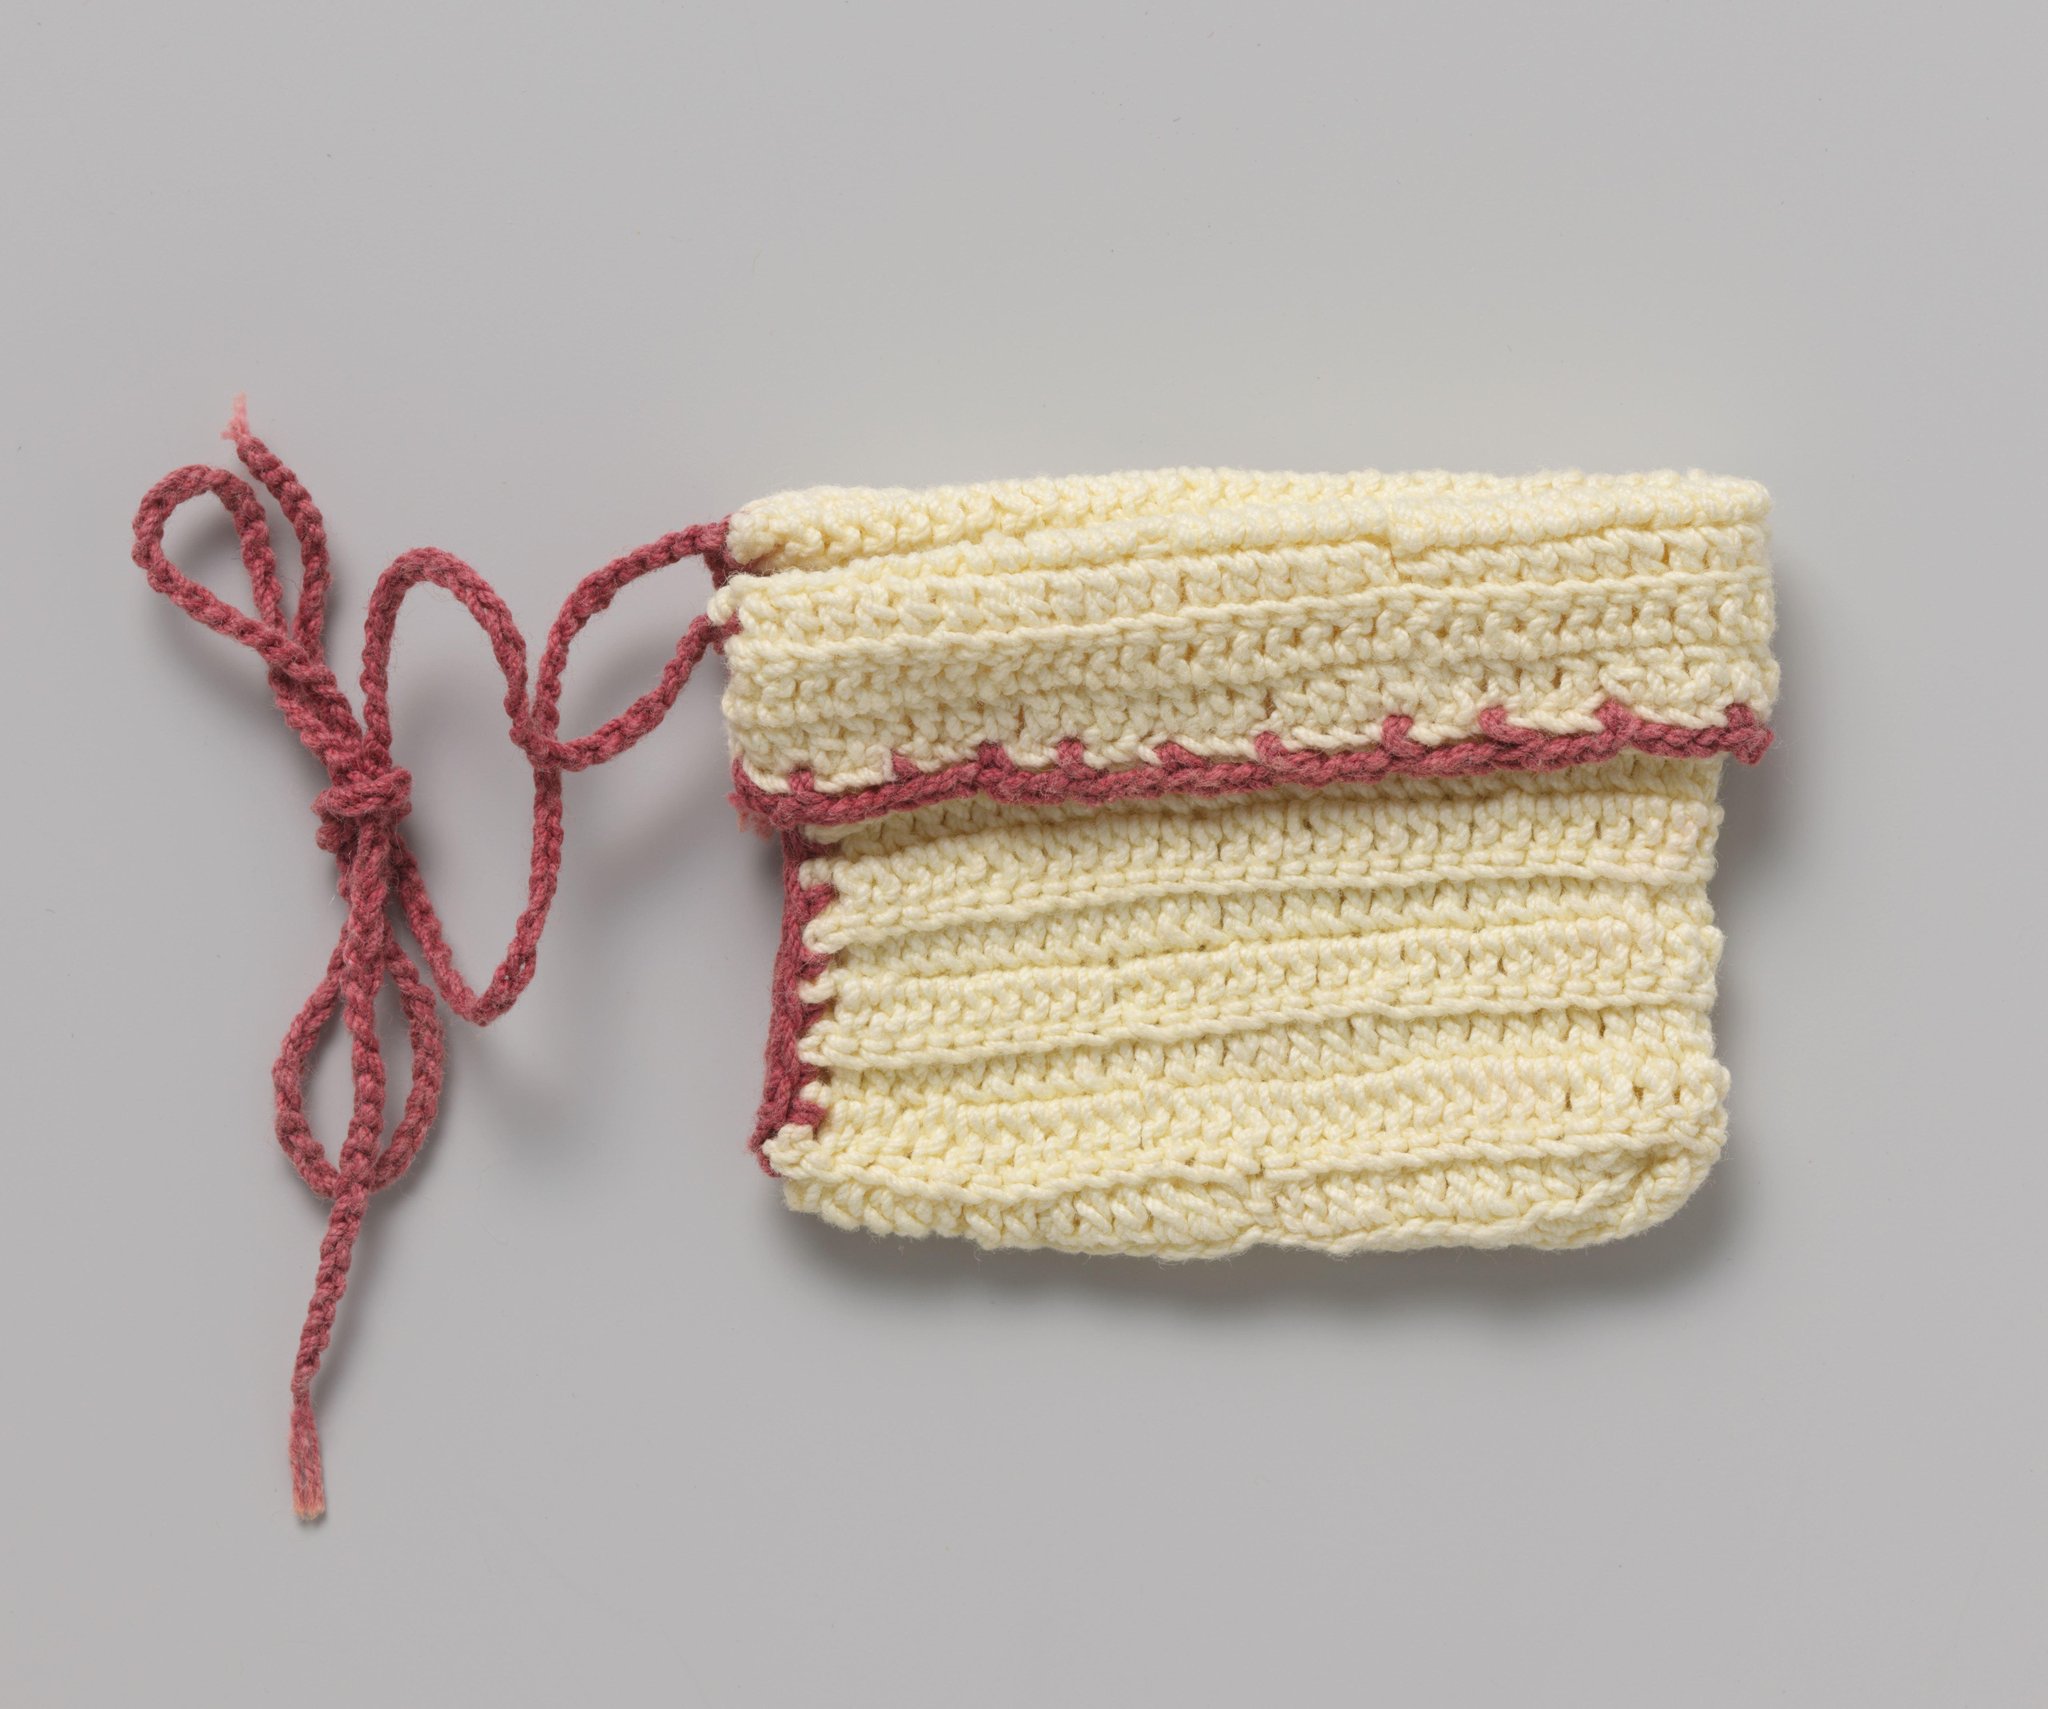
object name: cap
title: Muts van brei en/of haakwerk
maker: Anonymous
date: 1917-1920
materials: yarns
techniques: crochet, knitting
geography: amsterdam